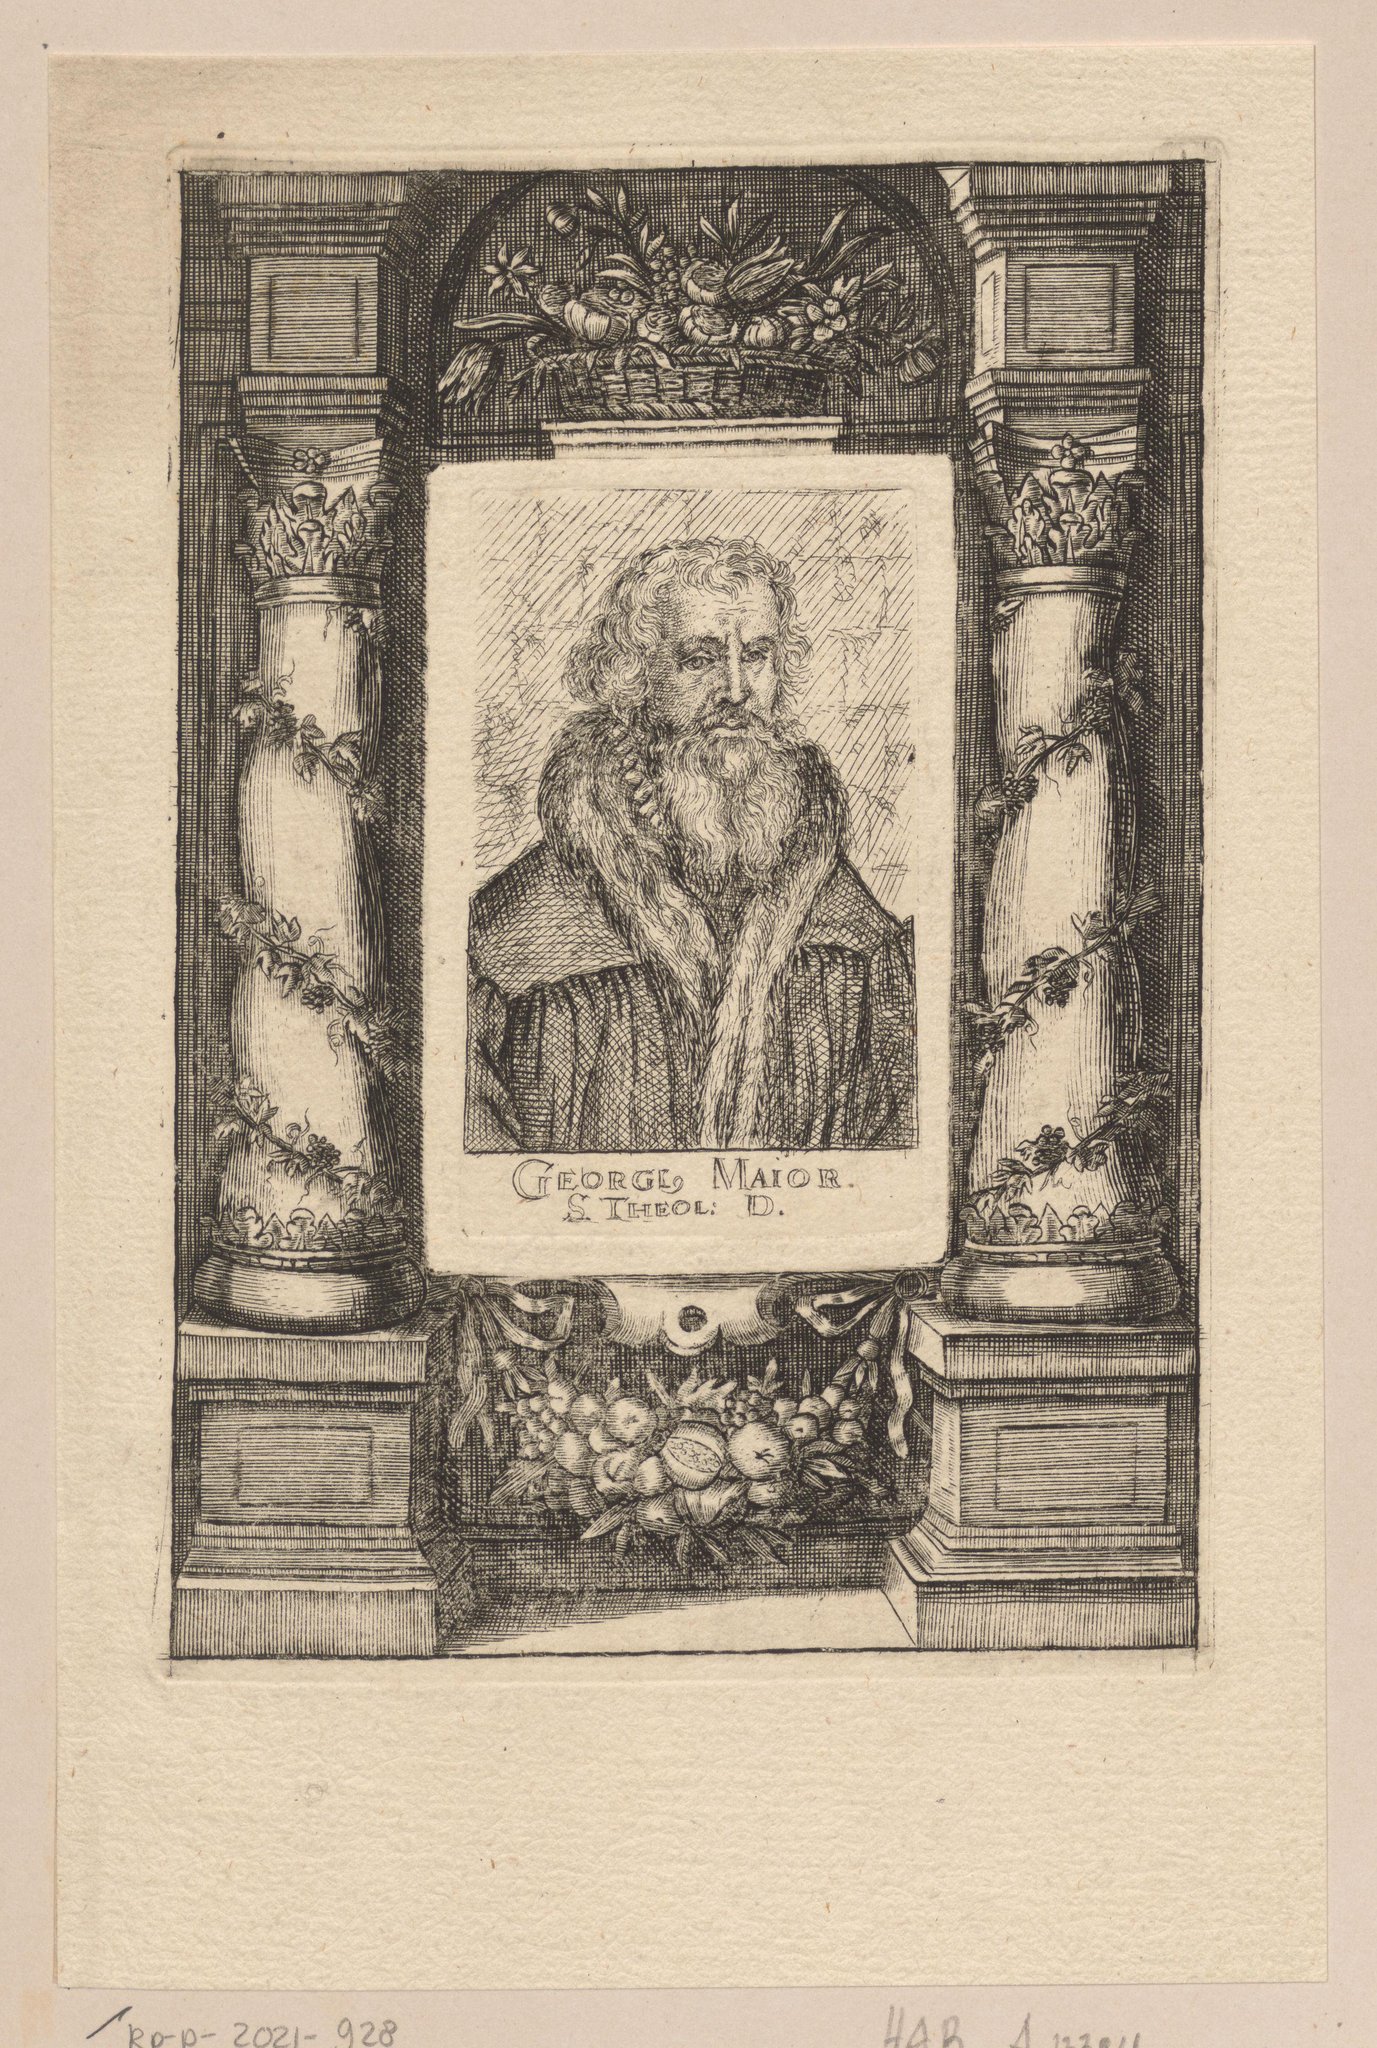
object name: print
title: Portret van Georg Major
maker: nicolaus häublin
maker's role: print maker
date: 1650-1685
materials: paper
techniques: engraving, etching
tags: historical persons, mistress